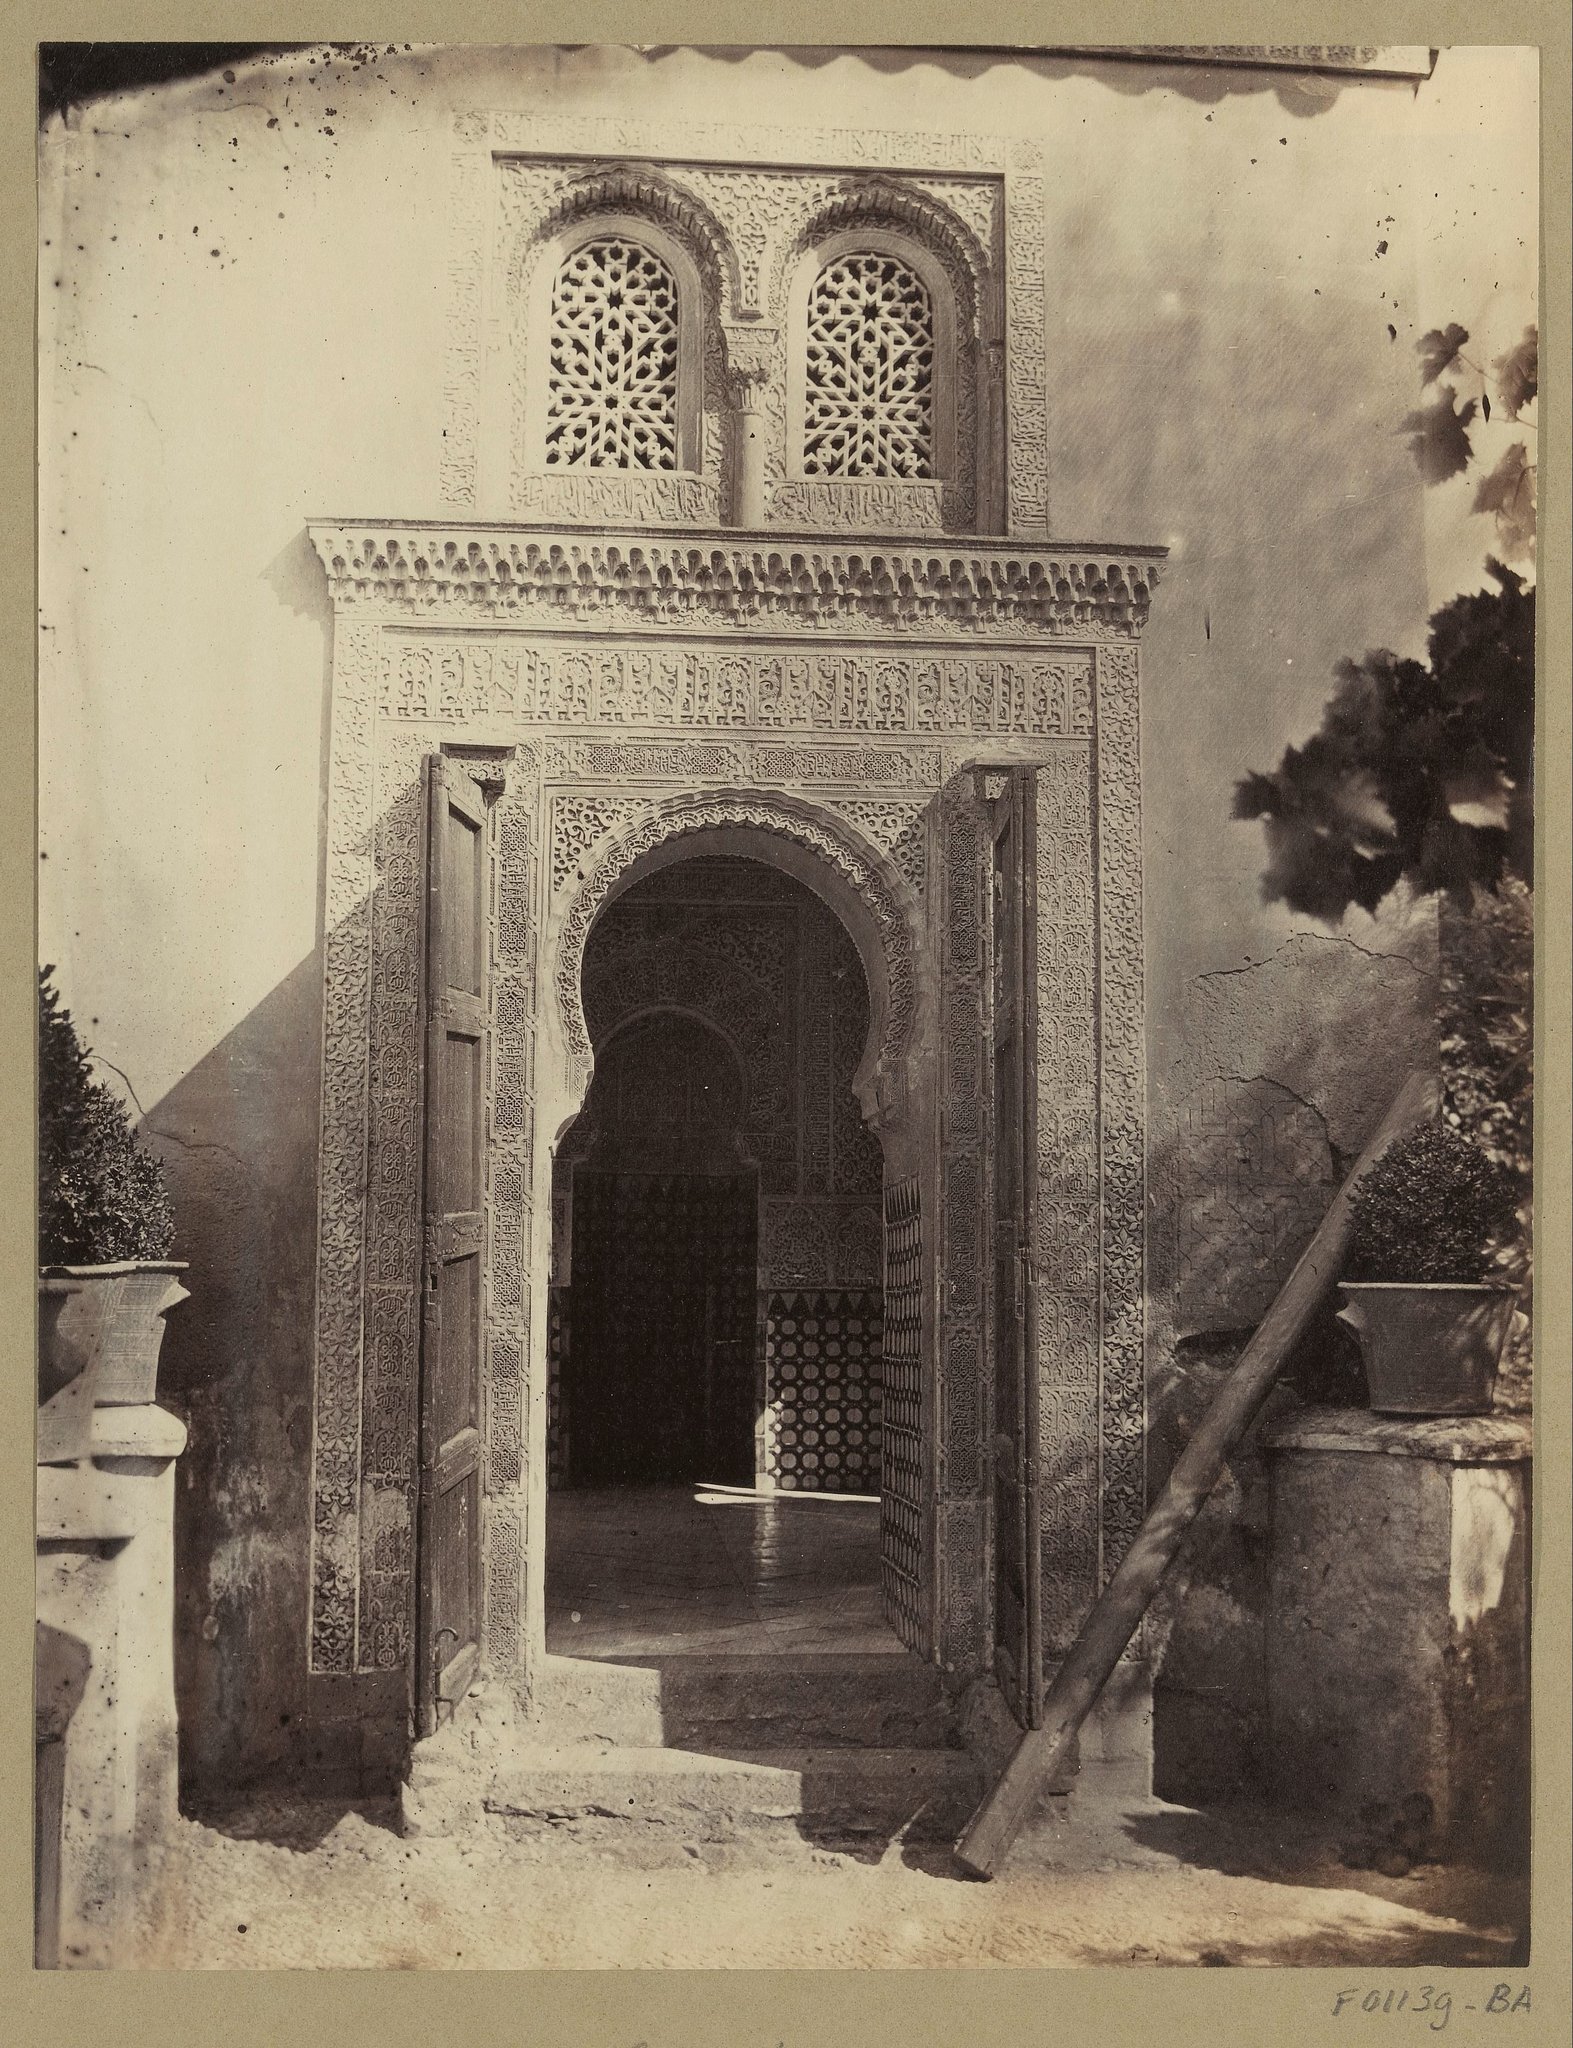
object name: album leaf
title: Gezicht op een portaal naar de mihrāb in het Alhambra in Granada, Spanje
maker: Anonymous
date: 1851-1890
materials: paper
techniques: albumen print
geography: granada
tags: temple, shrine ~ islam, mohammedanism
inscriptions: inscription: ‘Alhambra/ Granada/ La Mezquita’